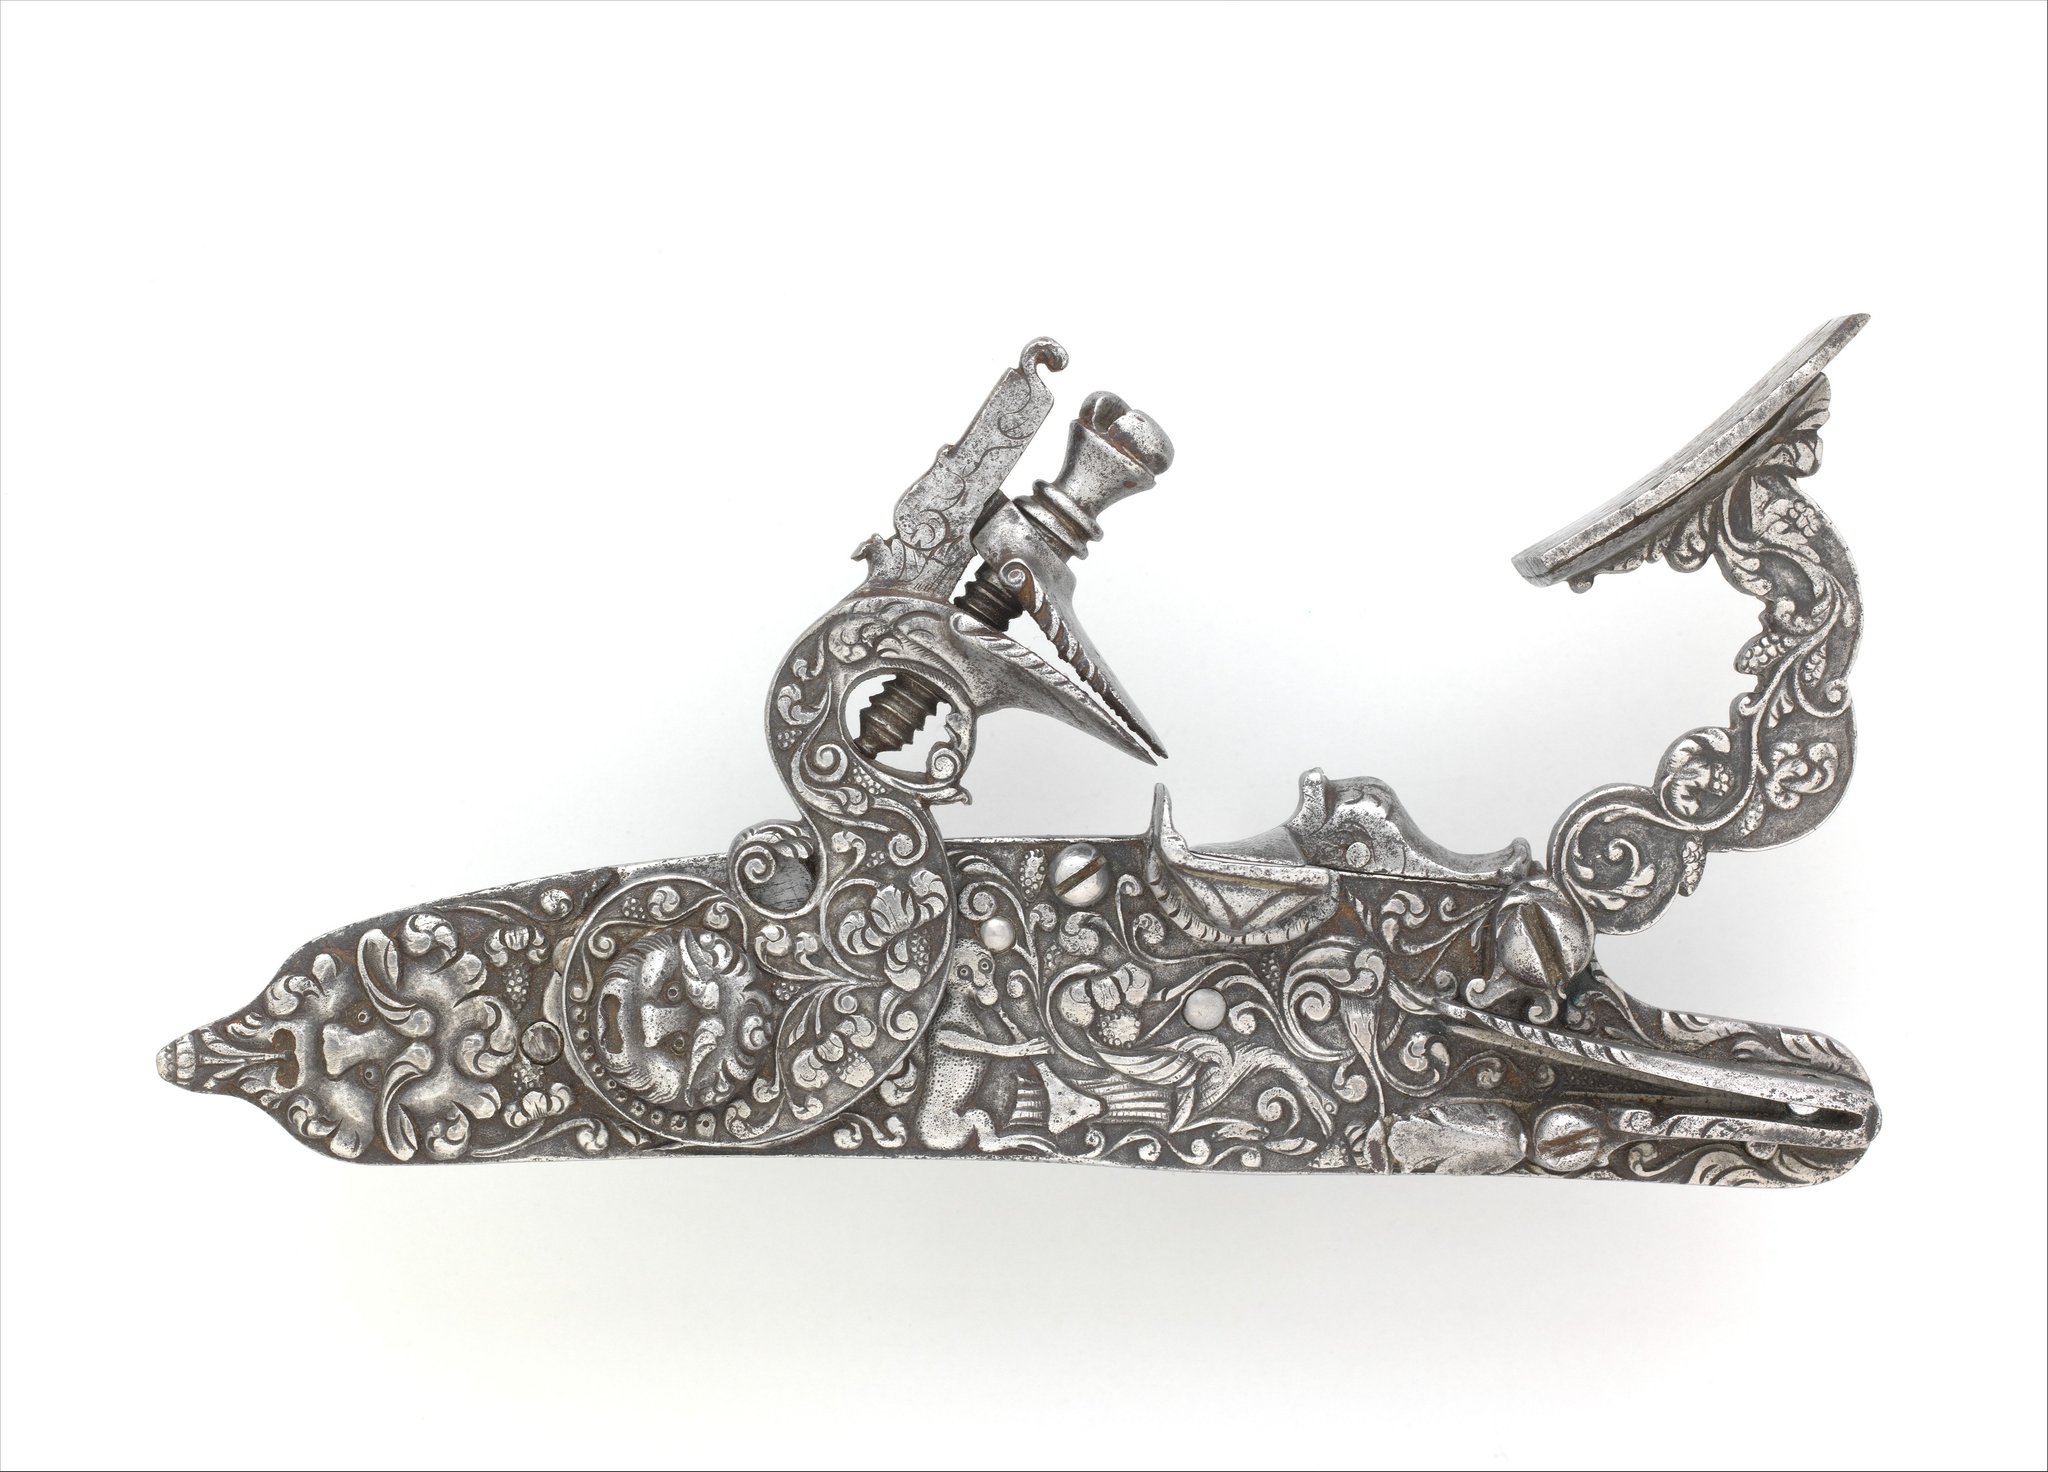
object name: snaphaunce lock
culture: german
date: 1601-1700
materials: steel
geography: germany